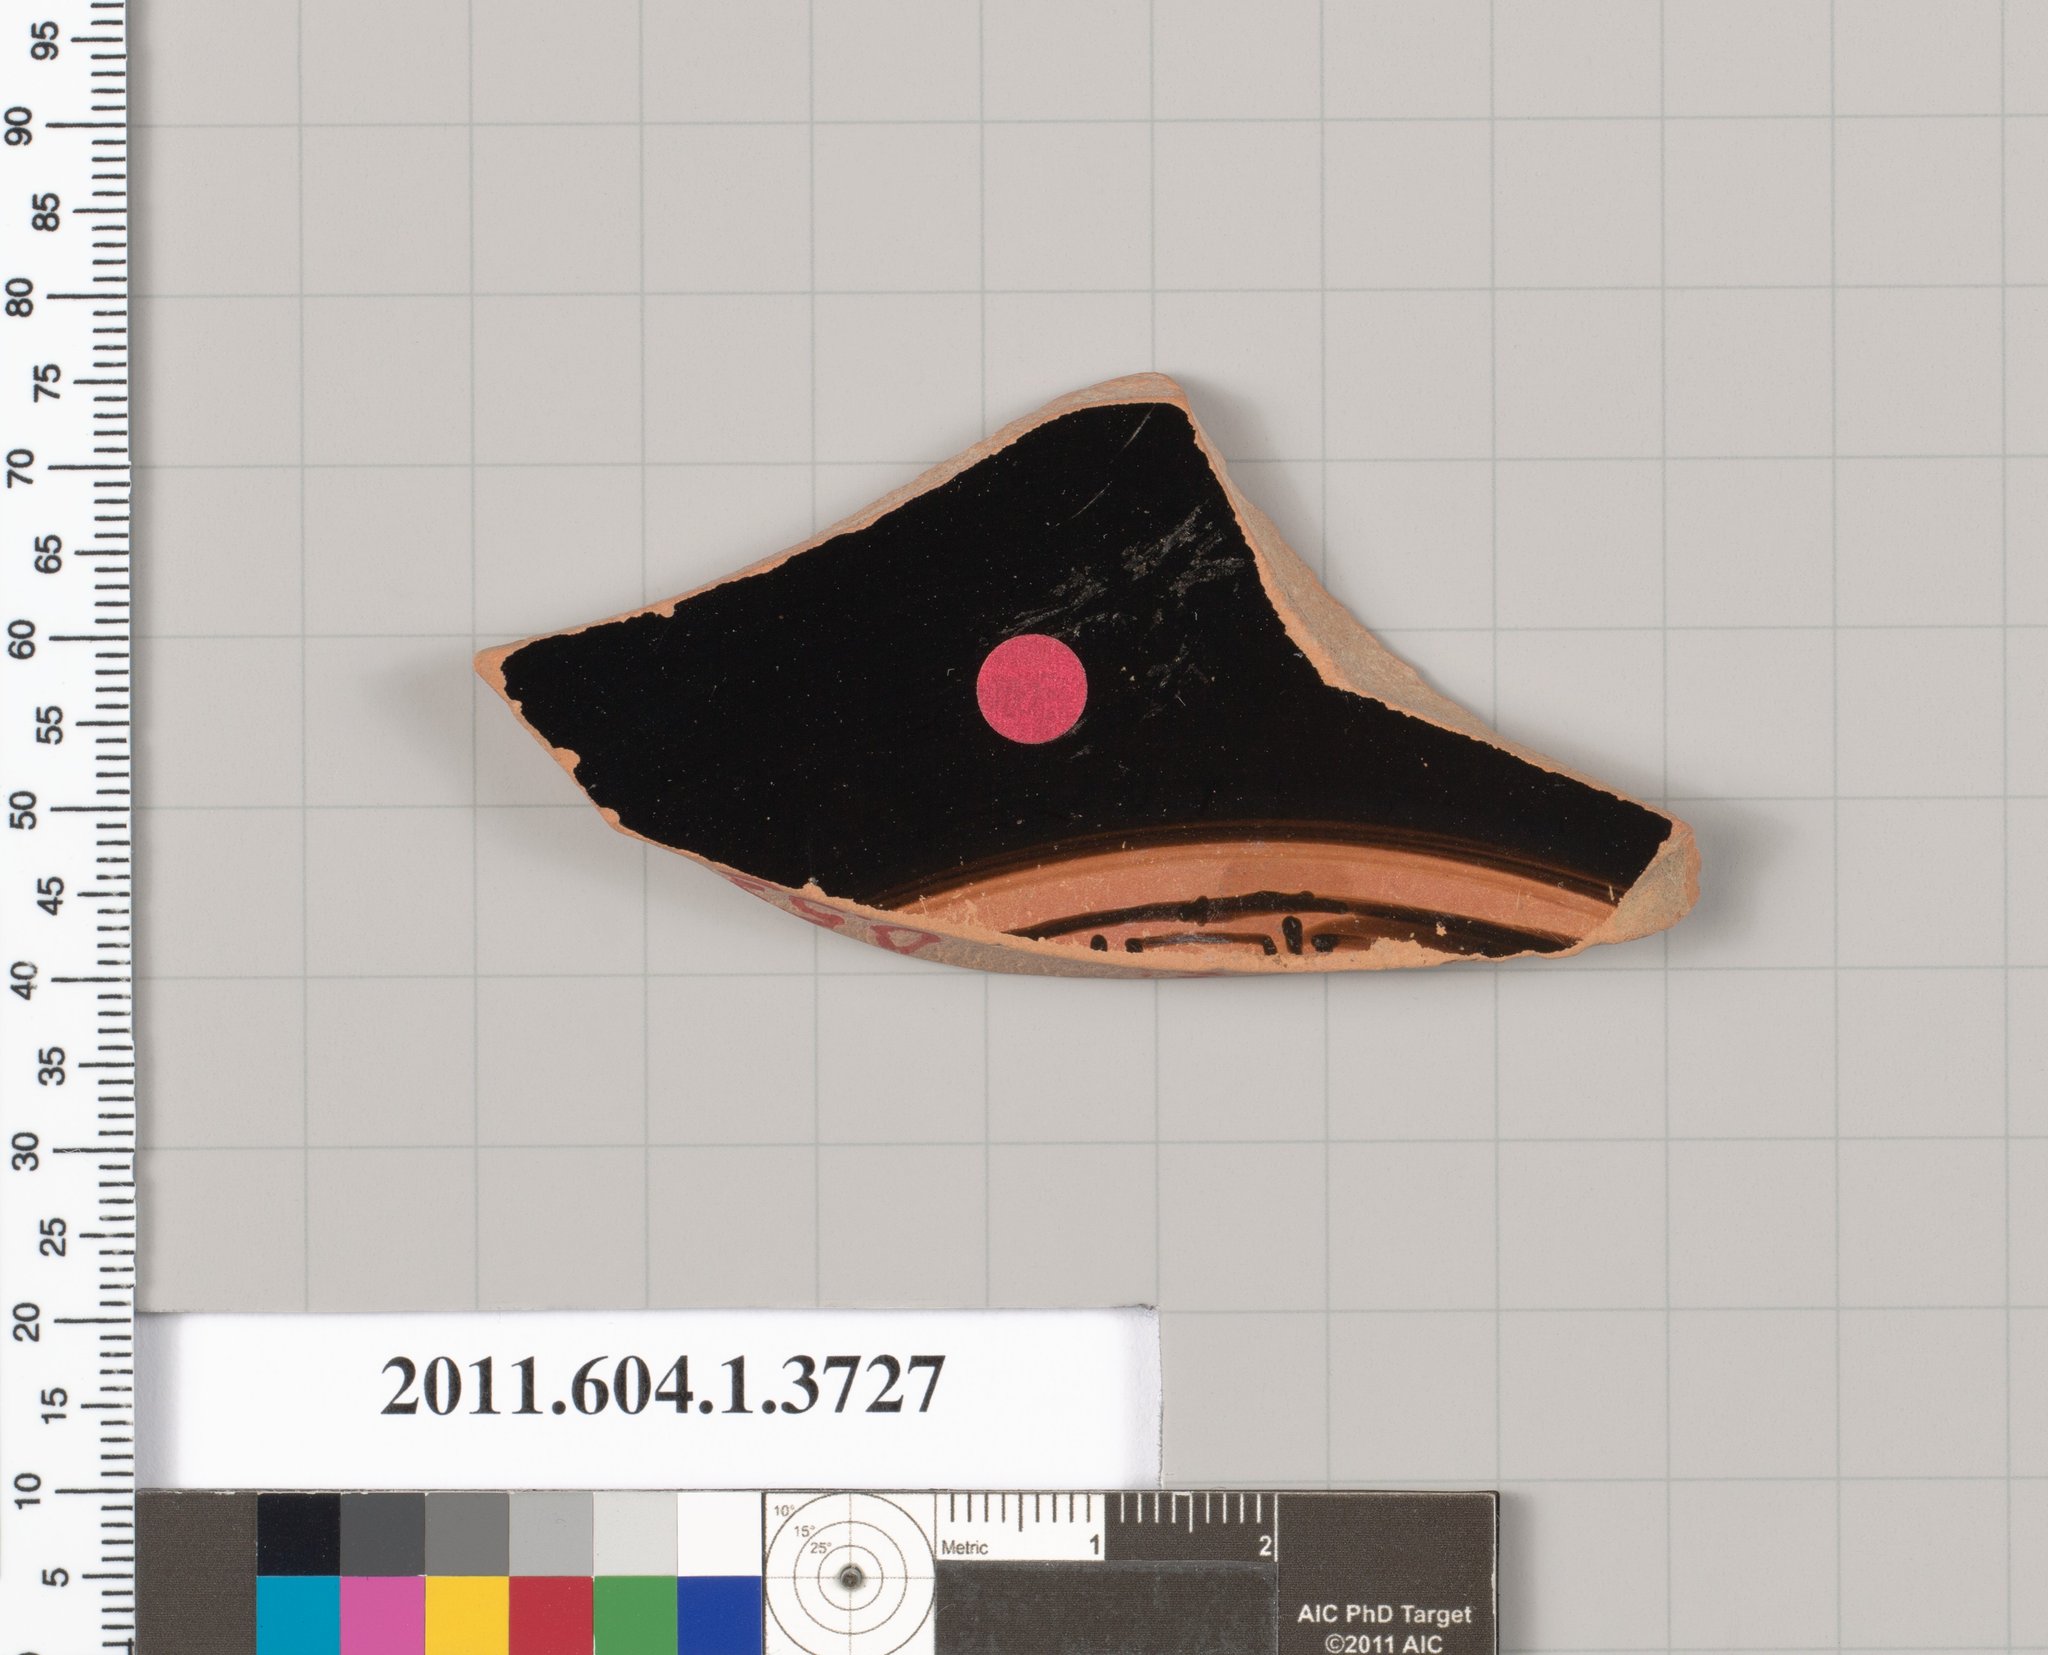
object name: kylix fragment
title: Terracotta fragment of a kylix (drinking cup)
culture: greek, attic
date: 475-451 BCE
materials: terracotta